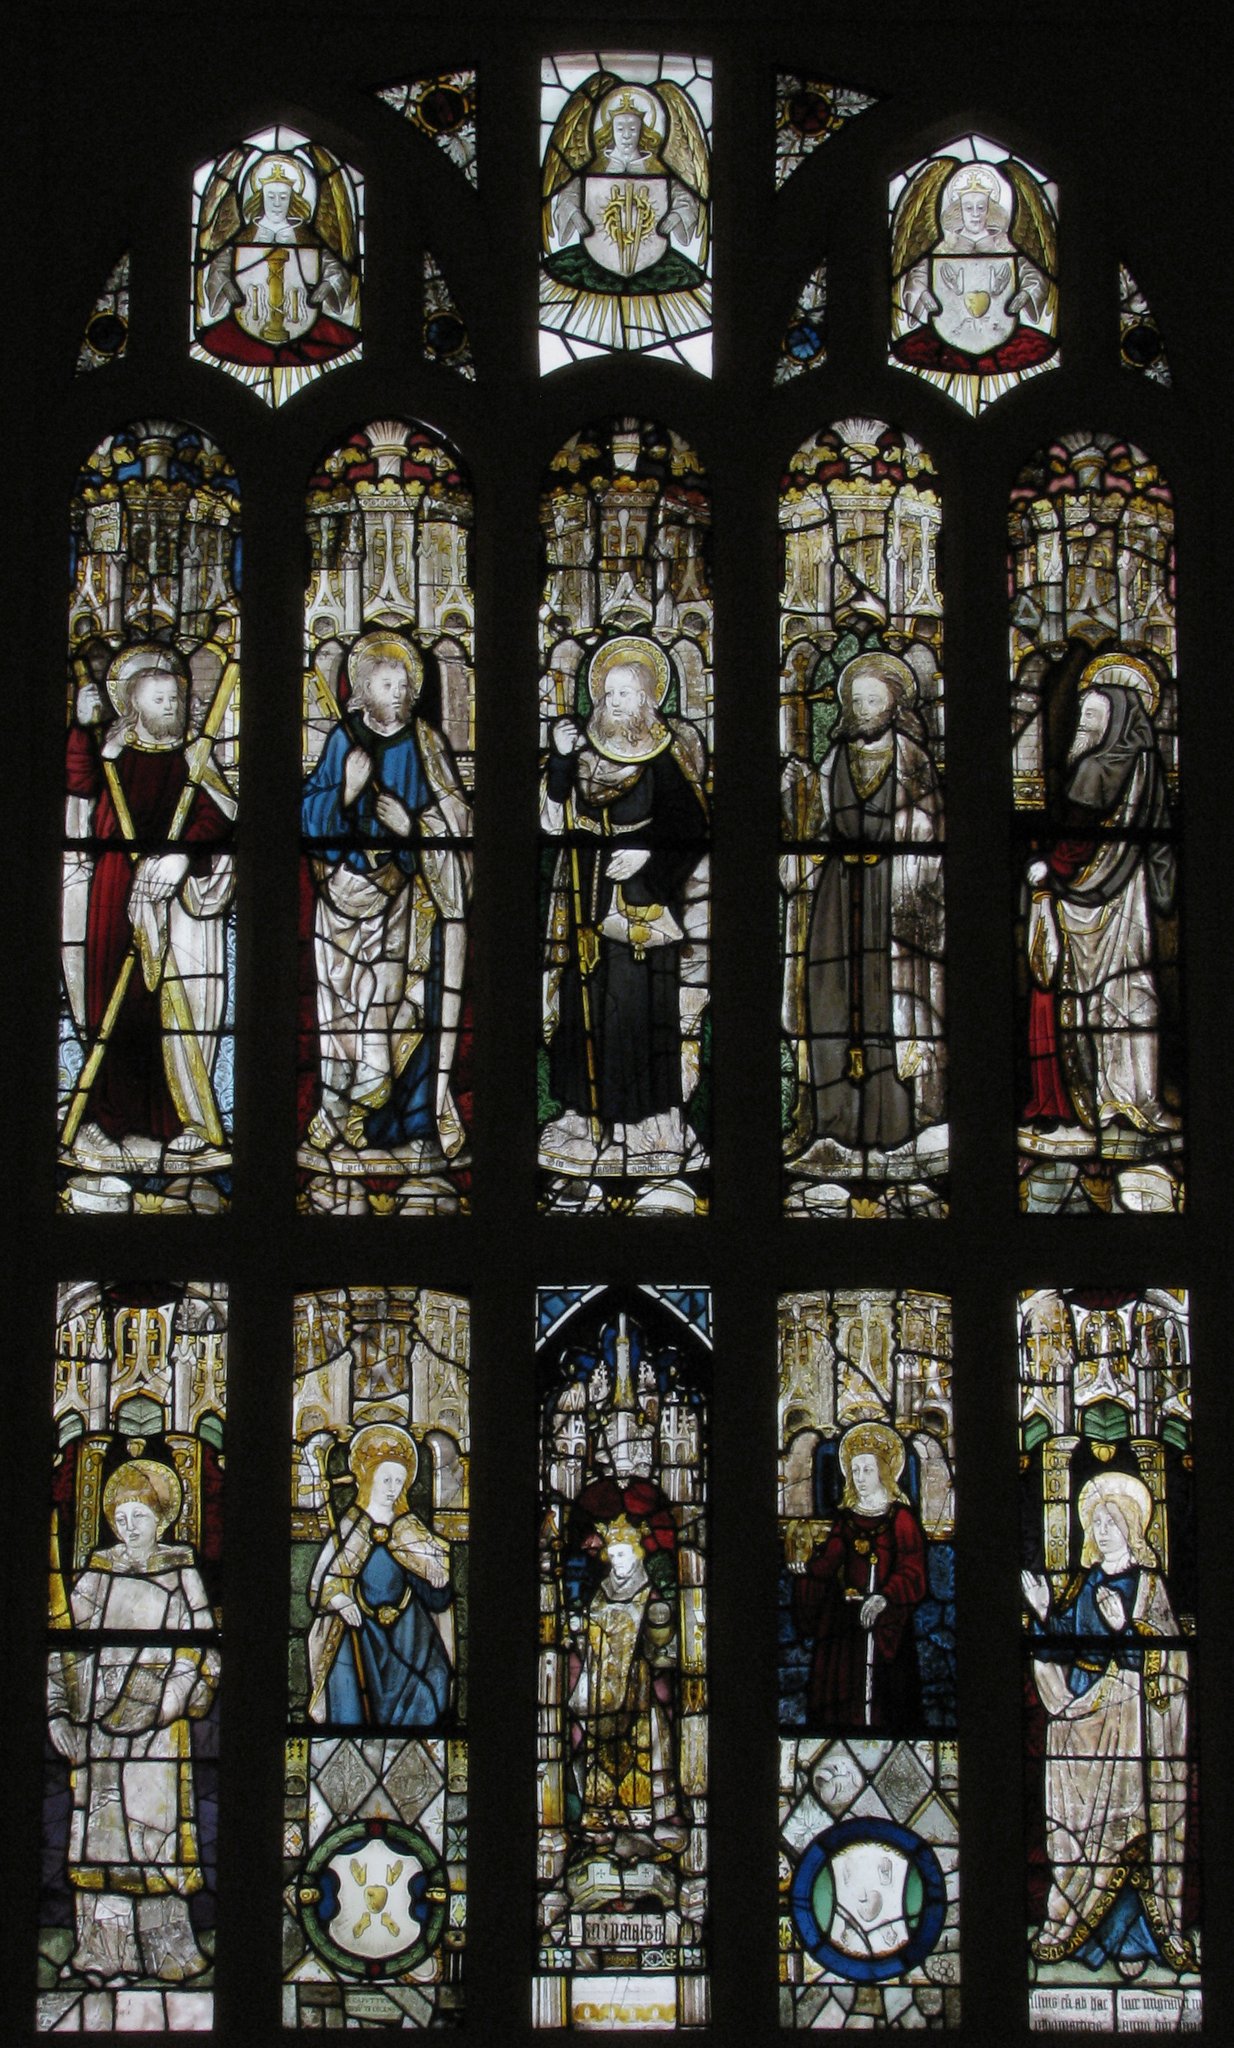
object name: window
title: Composite Window of English Stained Glass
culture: british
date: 1401-1500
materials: glass, metal, paint, pigment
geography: england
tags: angels,apostles,saints,coat of arms,evangelists